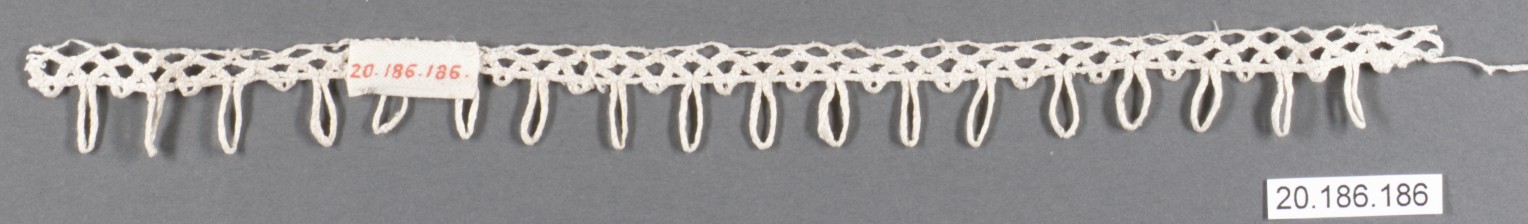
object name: edging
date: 1501-1550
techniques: lace